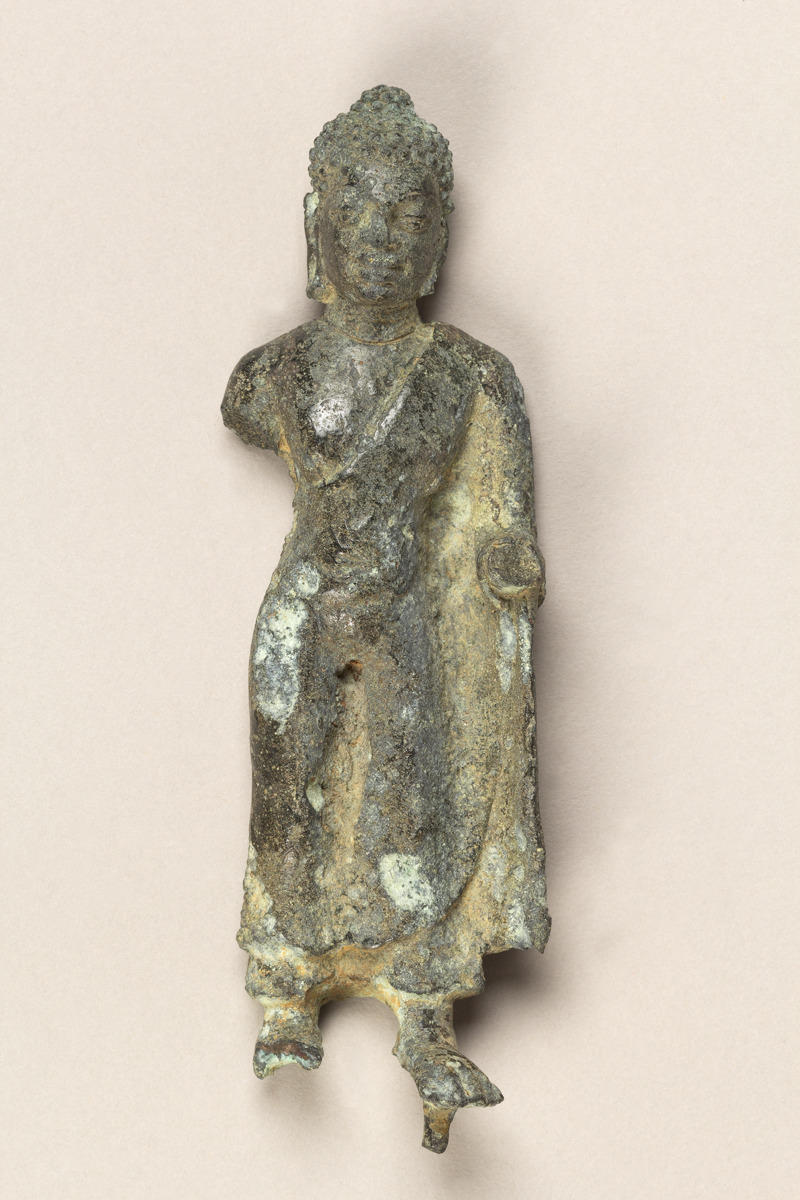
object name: fragment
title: Fragment of a Standing Buddha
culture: indonesian, kalimantan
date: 701-800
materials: bronze